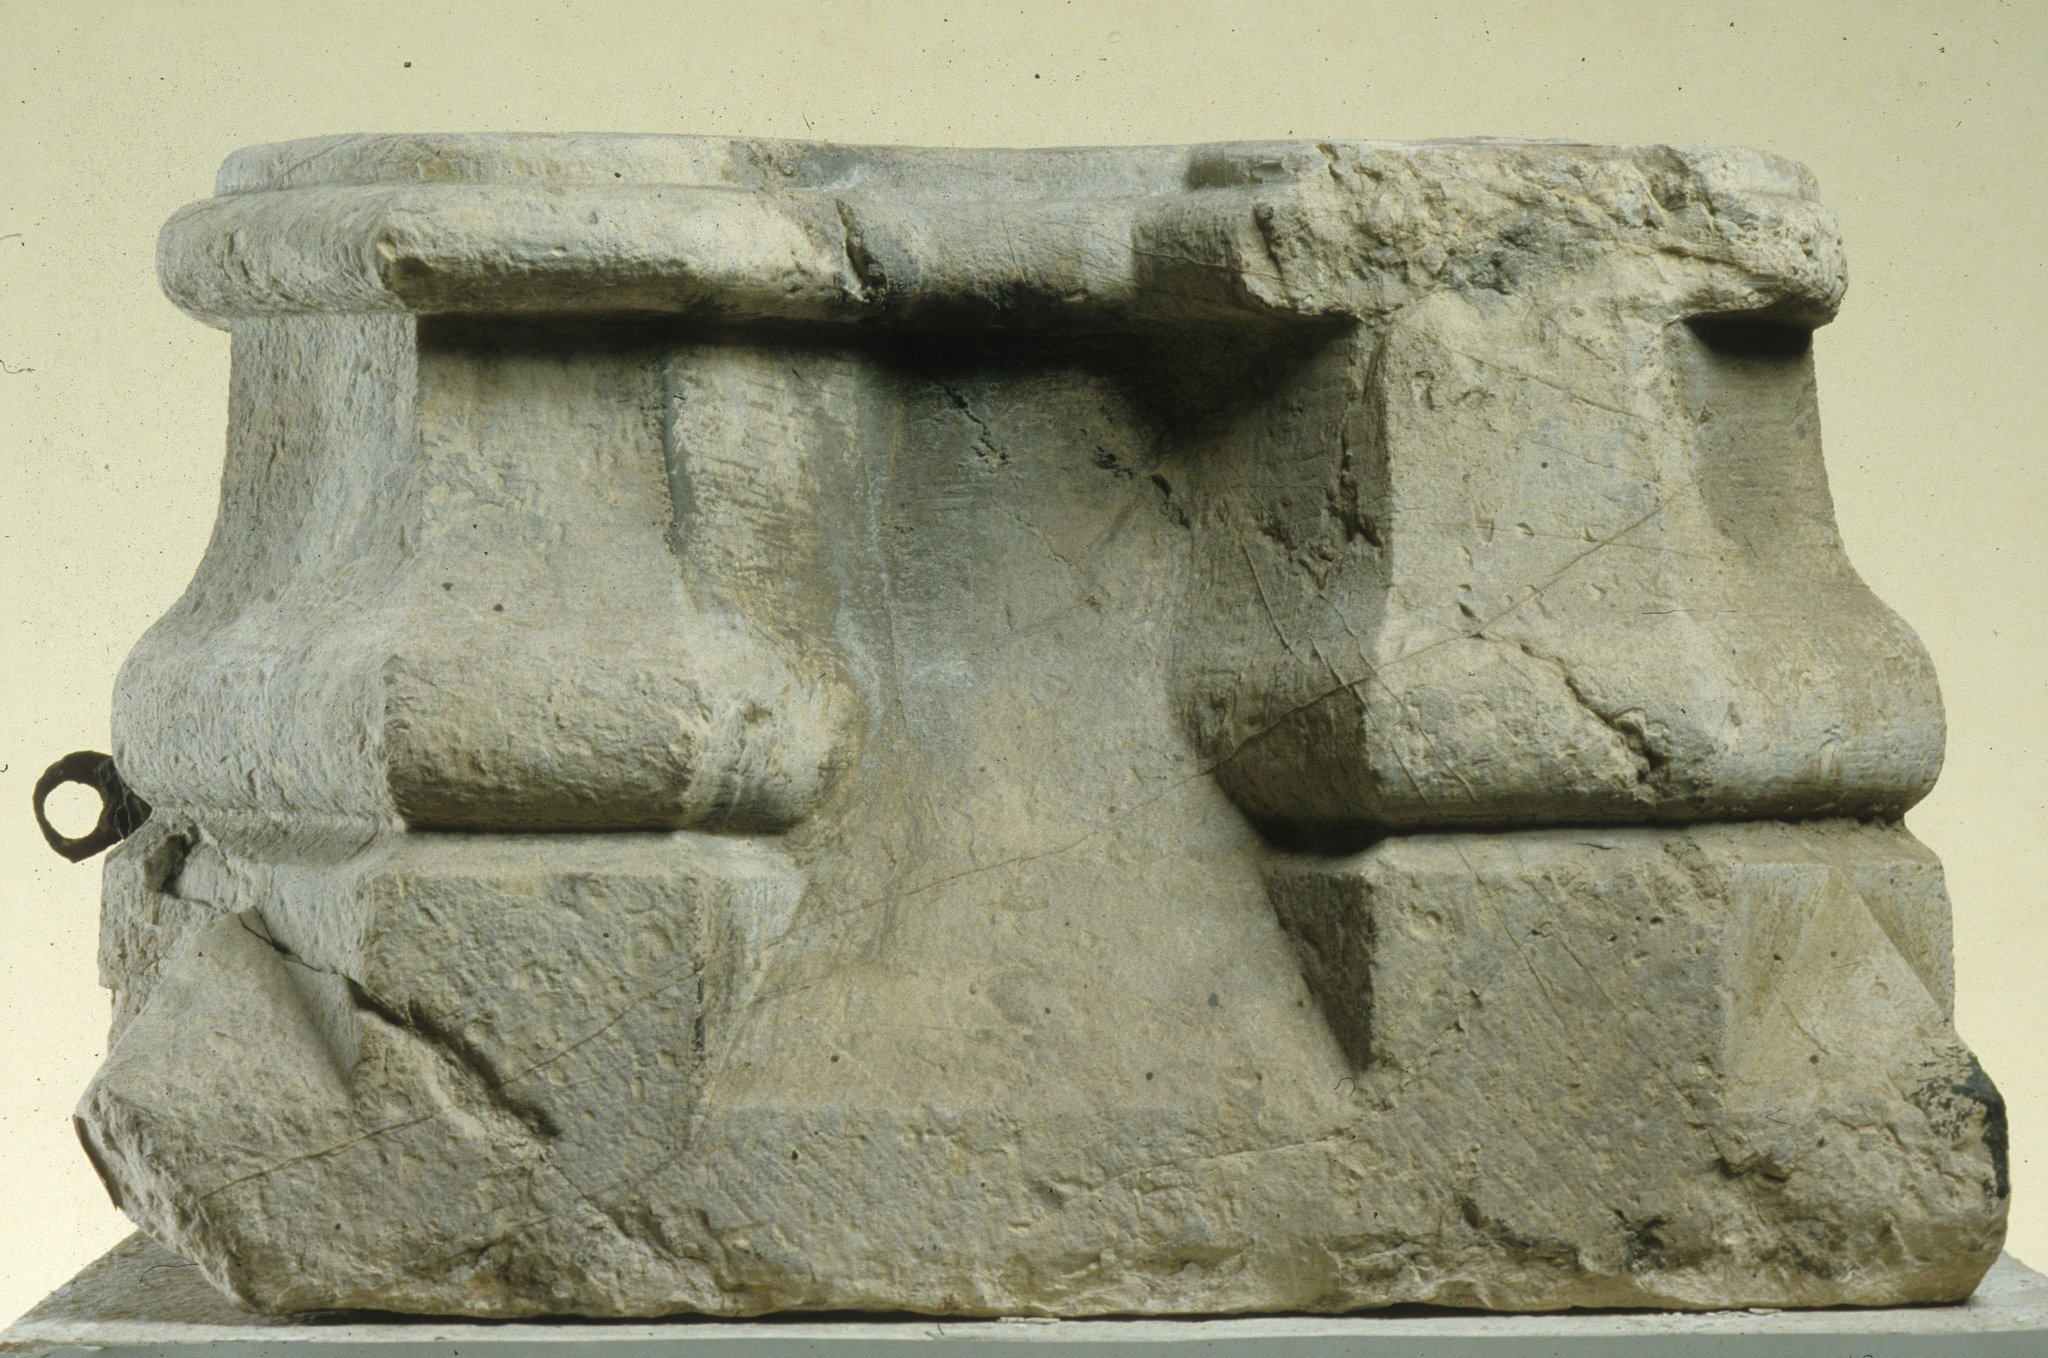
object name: base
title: Double Column Base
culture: french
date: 1467-1500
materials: marble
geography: france